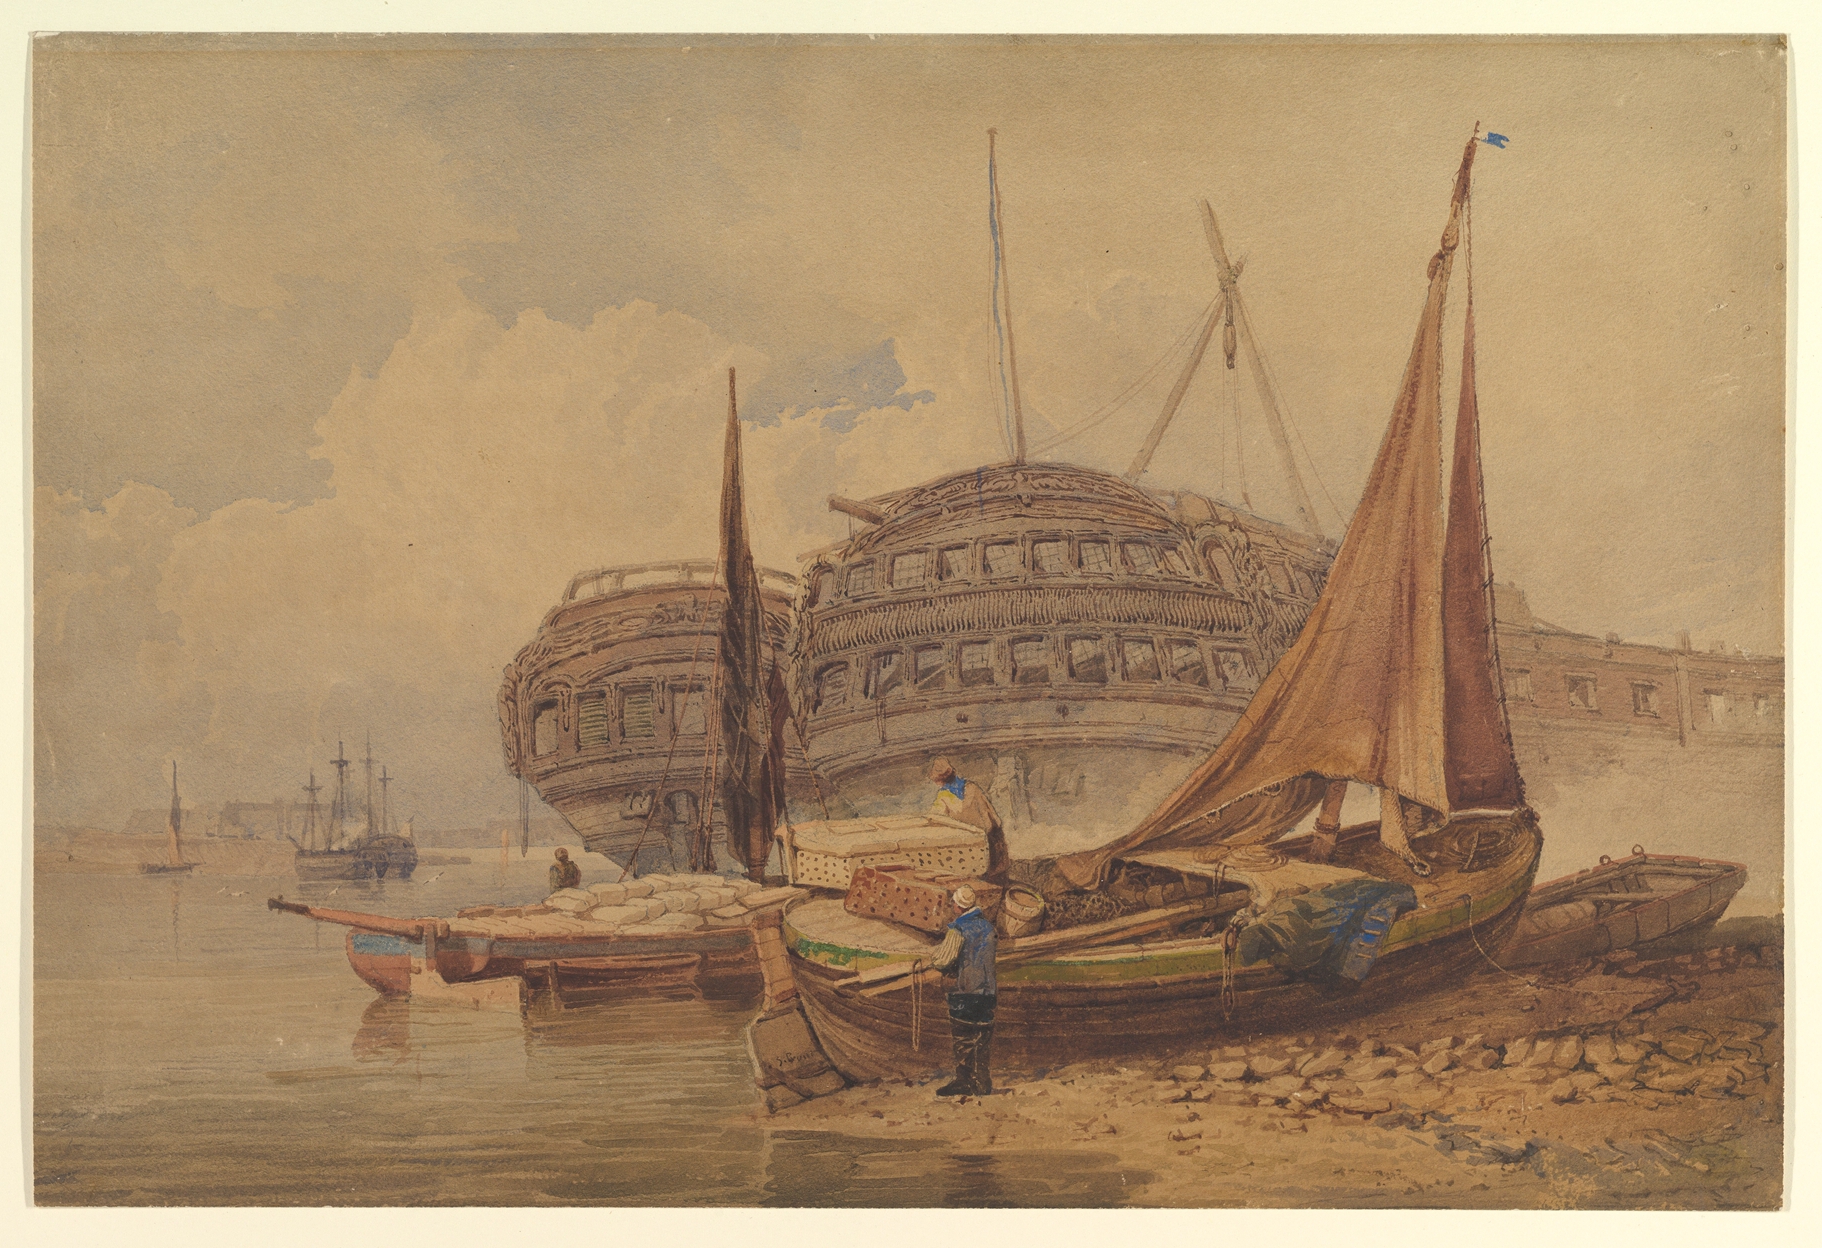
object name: drawing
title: Coastal Scene with Beached Boats in Foreground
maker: samuel prout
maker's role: artist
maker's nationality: british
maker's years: 1783-1852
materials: watercolor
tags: boats